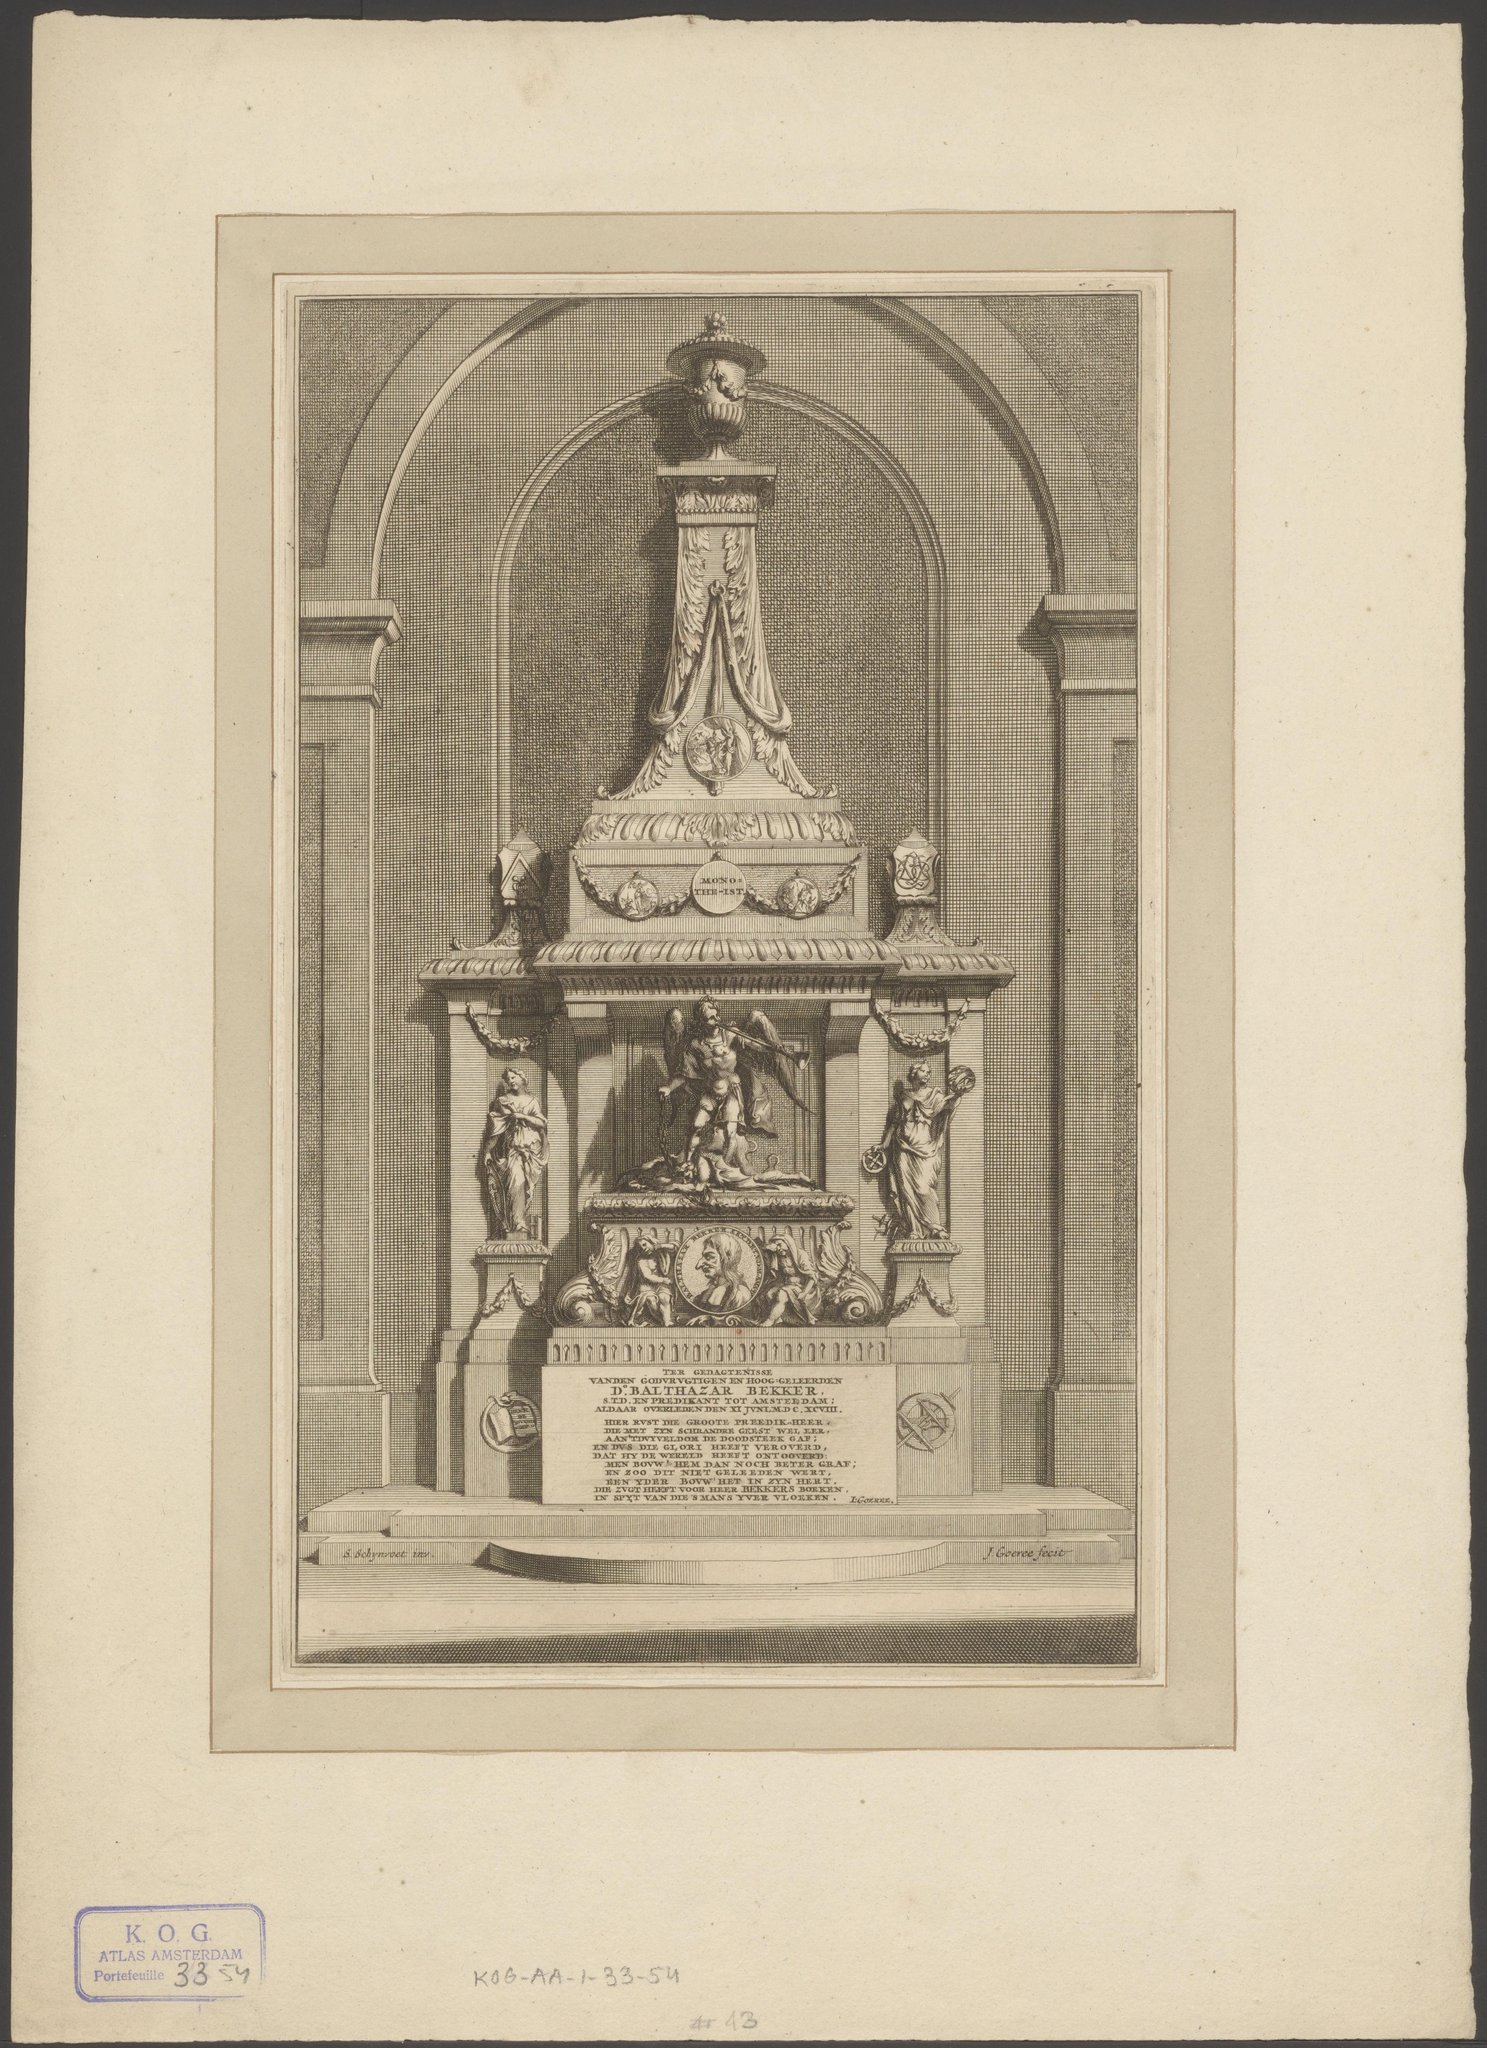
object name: print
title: Grafmonument van Balthasar Bekker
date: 1742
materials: paper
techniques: engraving, etching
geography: amsterdam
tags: amsterdam, balthasar bekker, grave-building, monumental tomb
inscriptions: collector's mark: Lugt 1641b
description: Prent mogelijk uit: S. Schynvoets voorbeelden der lusthof-cieraaden, zynde vaasen, pedestallen, orangiebakken, blompotten en andere bywerken &c. Amsterdam: Hermanus de Wit, [1742].